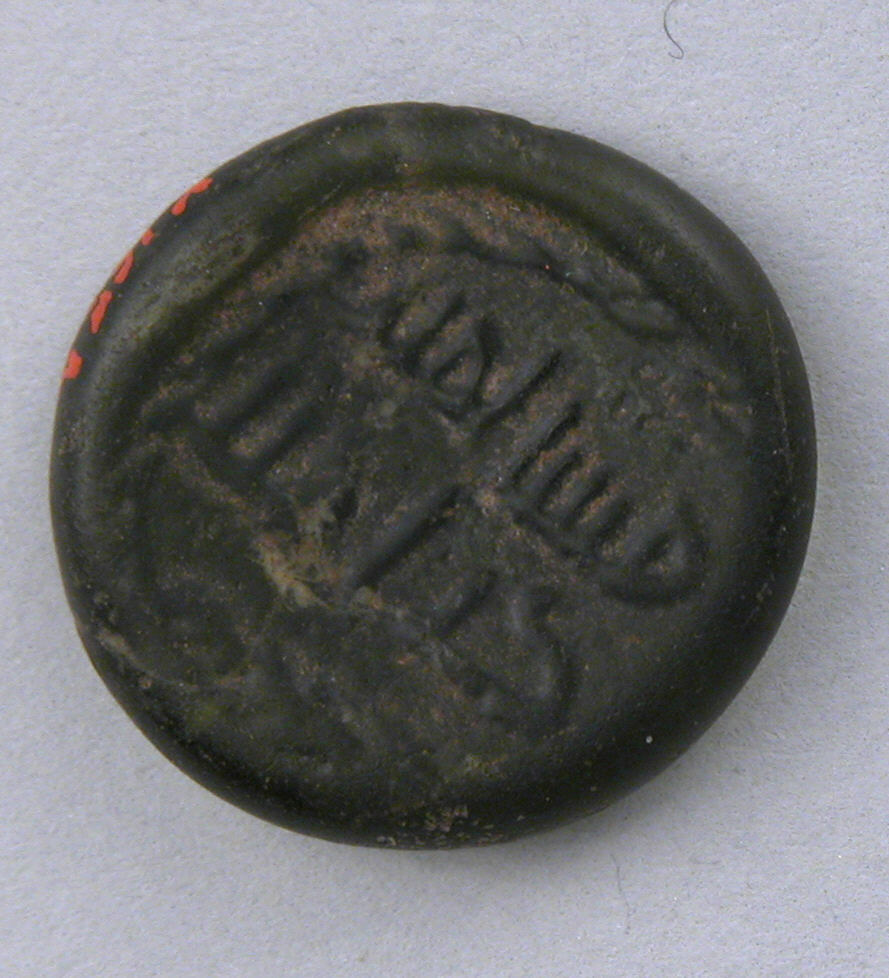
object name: coin weight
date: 1201-1400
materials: glass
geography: egypt